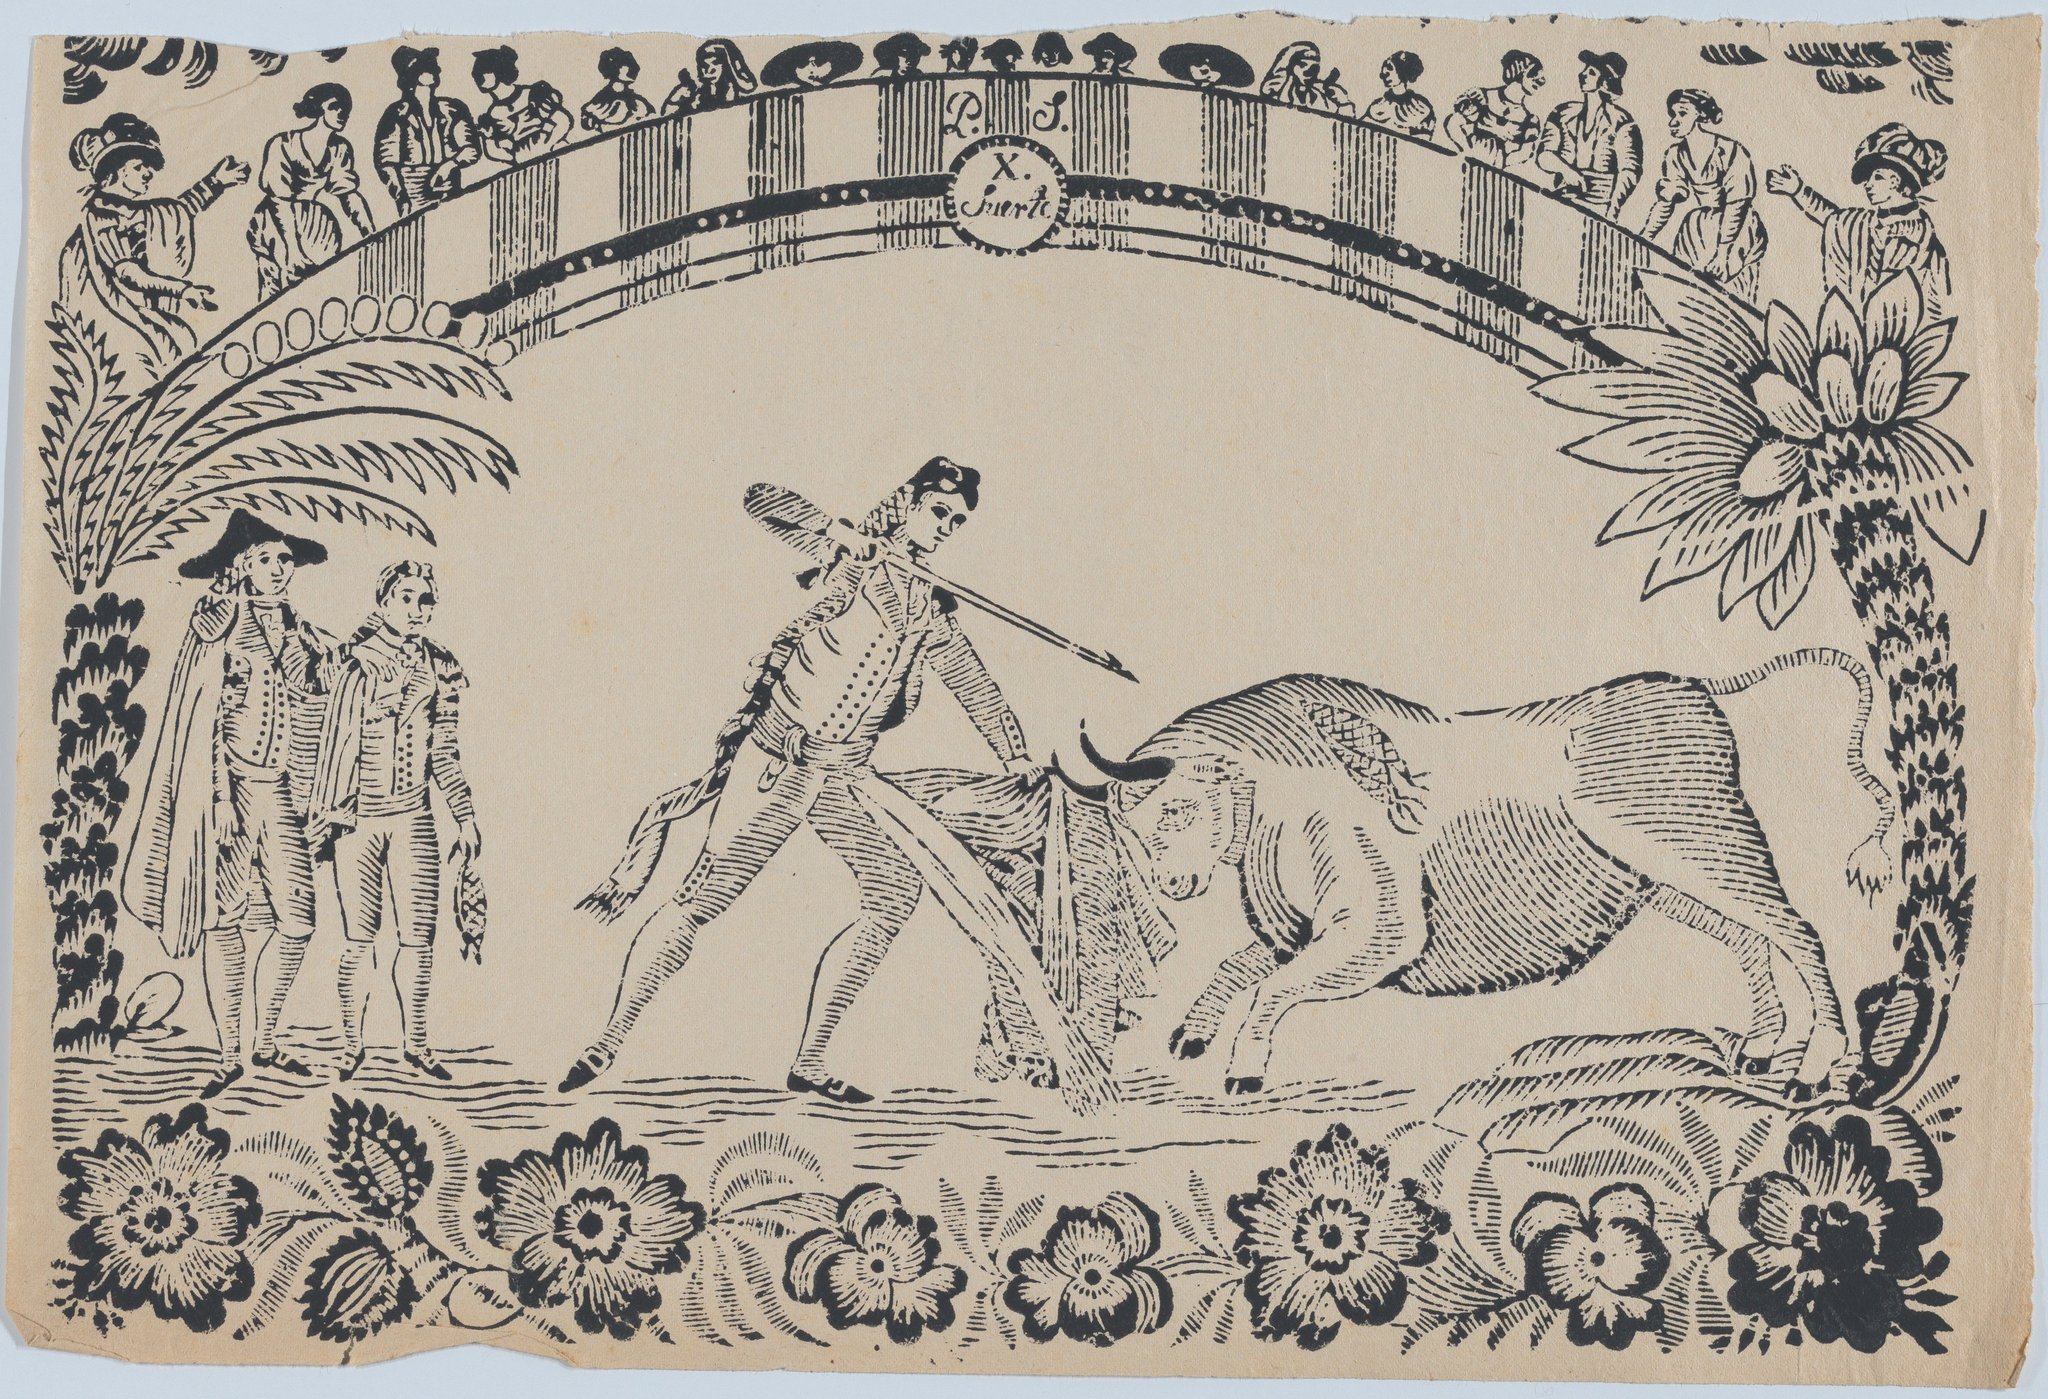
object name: print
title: Suerte X: A torero prepares to stab the bull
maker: anonymous, spanish, 19th century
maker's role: artist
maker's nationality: spanish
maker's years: 1800-1900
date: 1850-1880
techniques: woodcut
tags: men,bulls